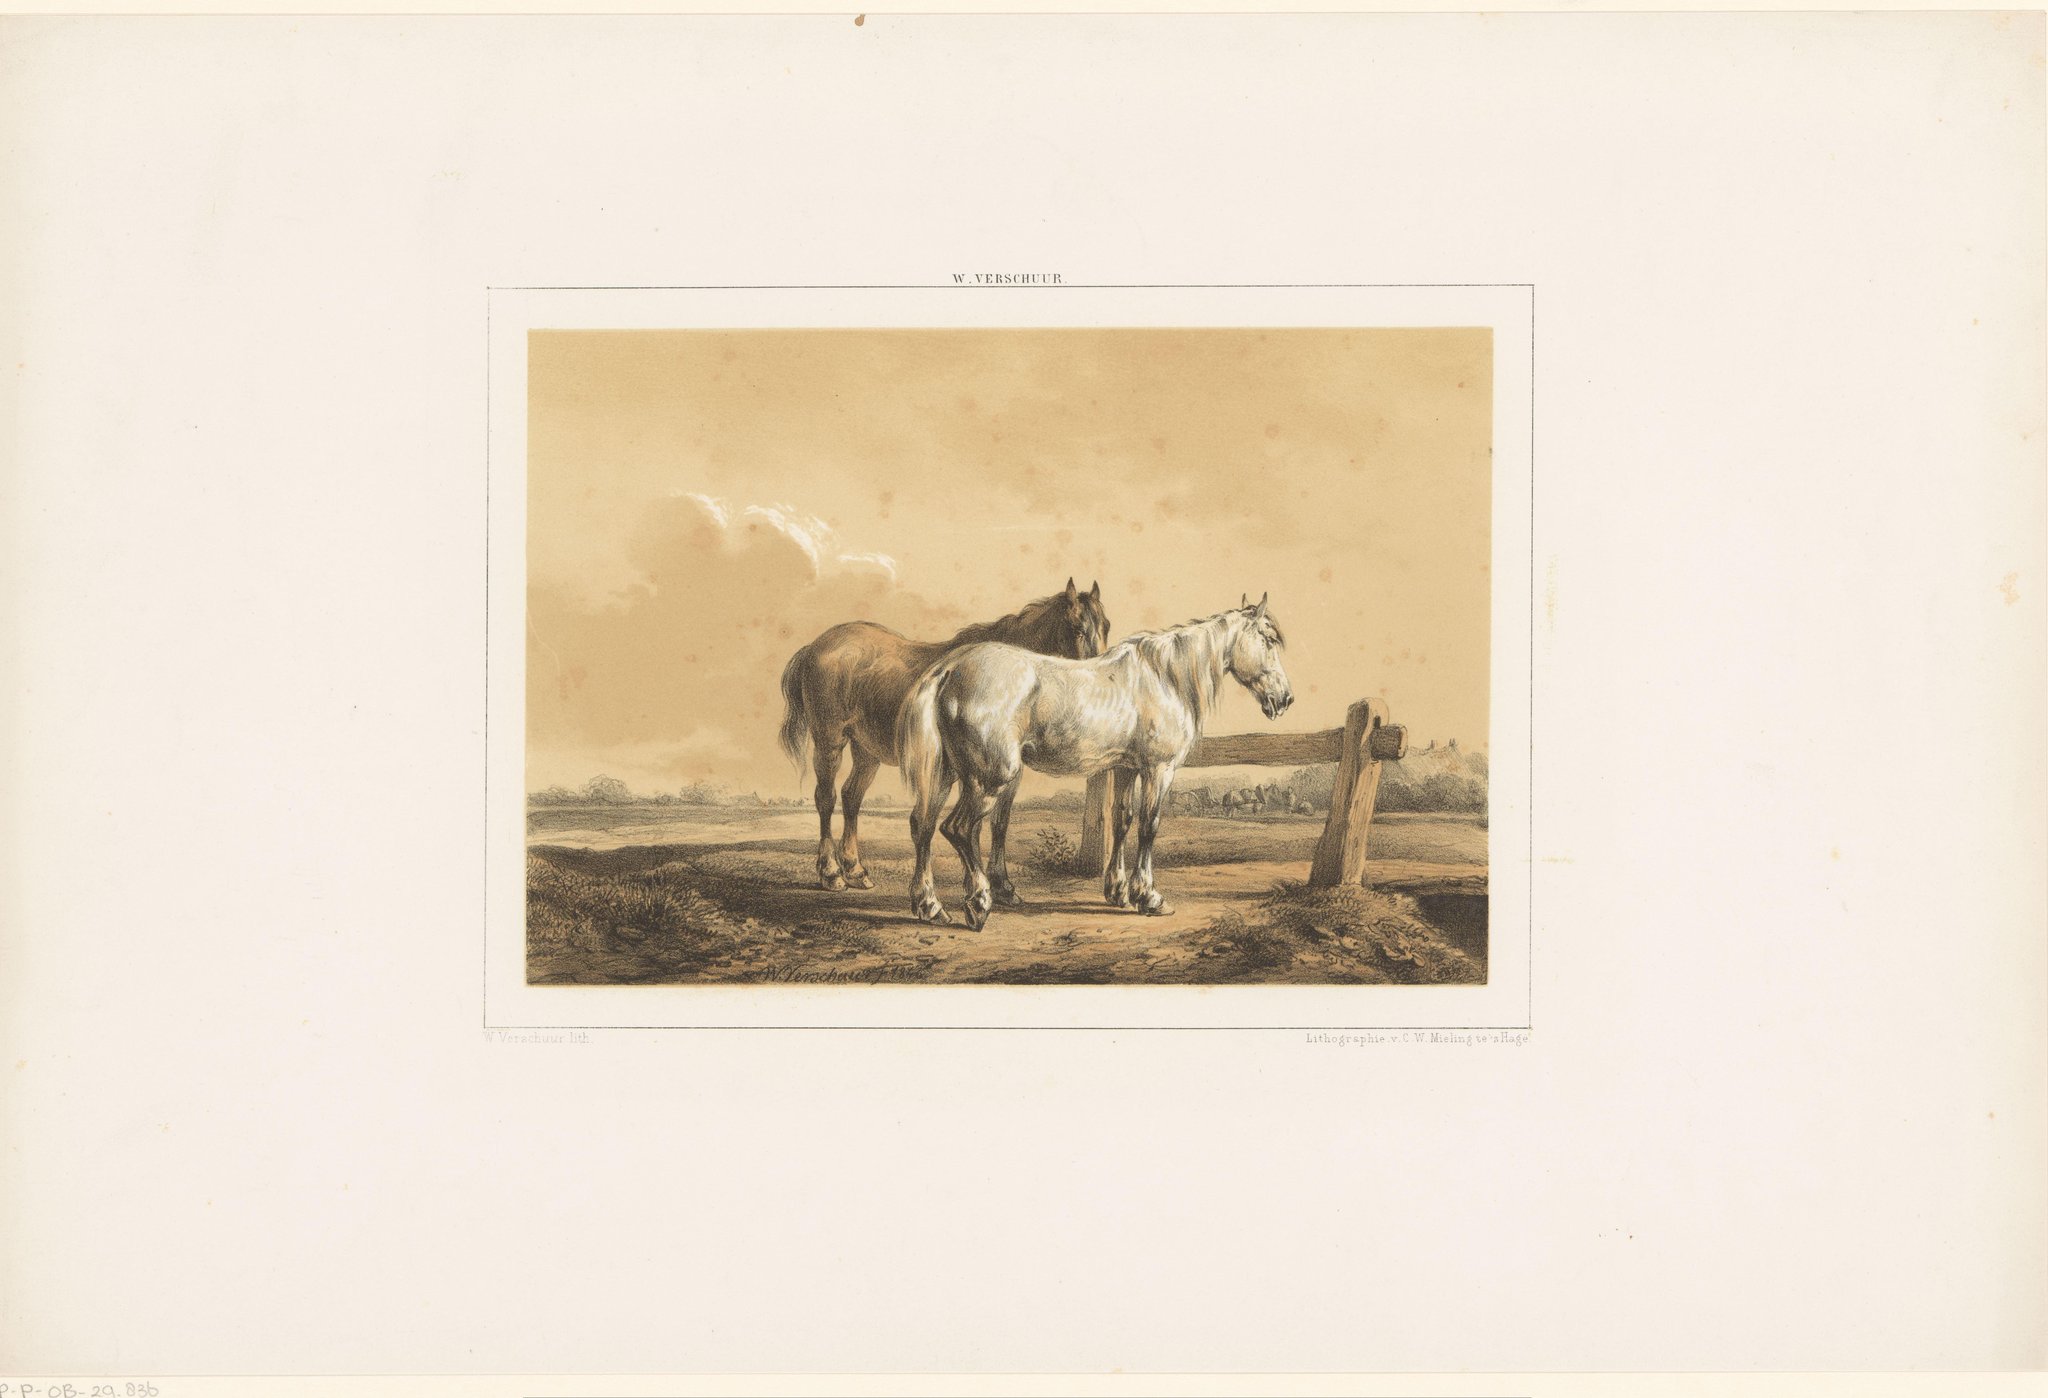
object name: print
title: Twee paarden in een wei bij een hek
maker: wouter verschuur (1812-1874)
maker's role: draughtsman, painter, print maker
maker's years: 1812-1874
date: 1848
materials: paper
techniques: tone lithography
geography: the hague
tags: horse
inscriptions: collector's mark: Lugt 2228